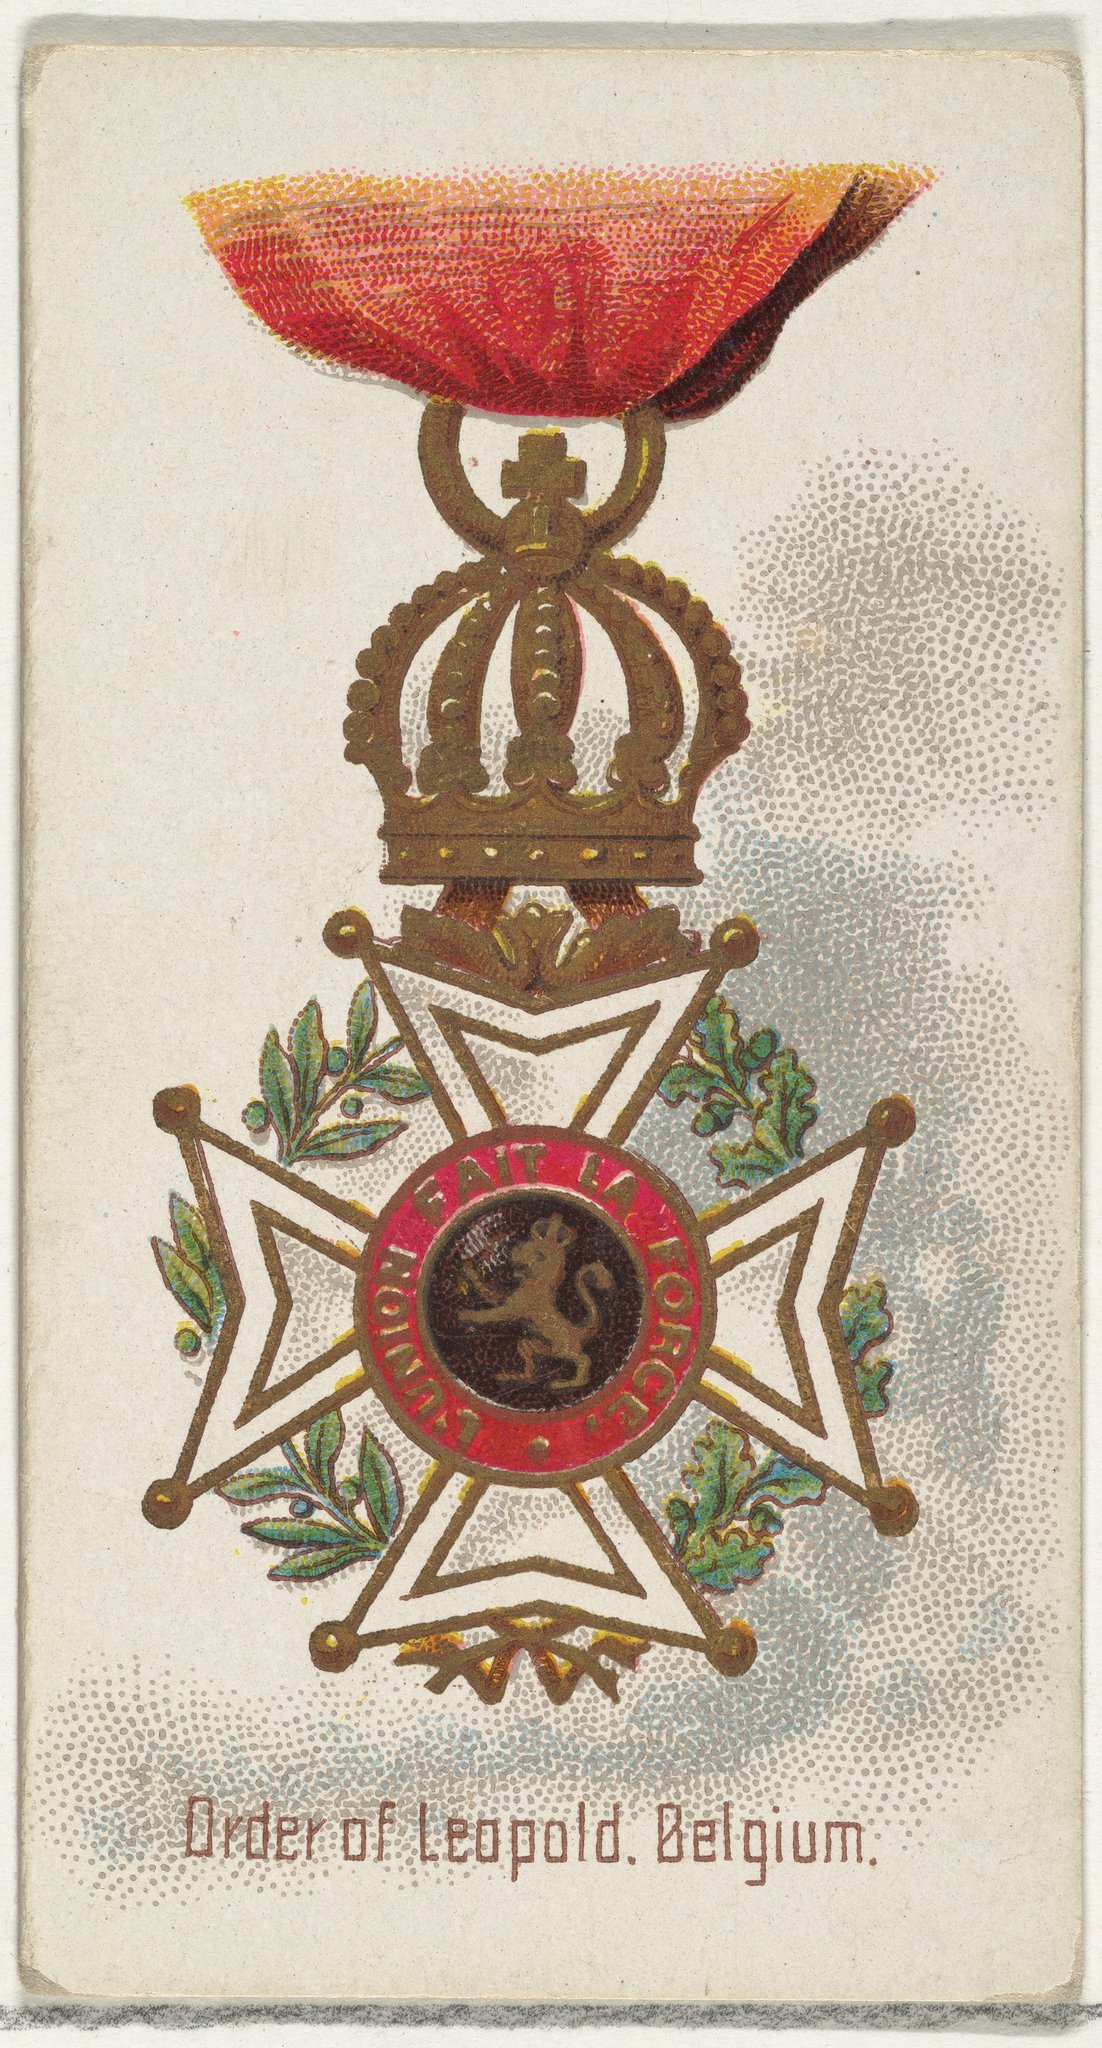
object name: print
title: Order of Leopold, Belgium, from the World's Decorations series (N30) for Allen & Ginter Cigarettes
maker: allen & ginter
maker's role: publisher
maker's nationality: american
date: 1890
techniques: color lithograph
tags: medals